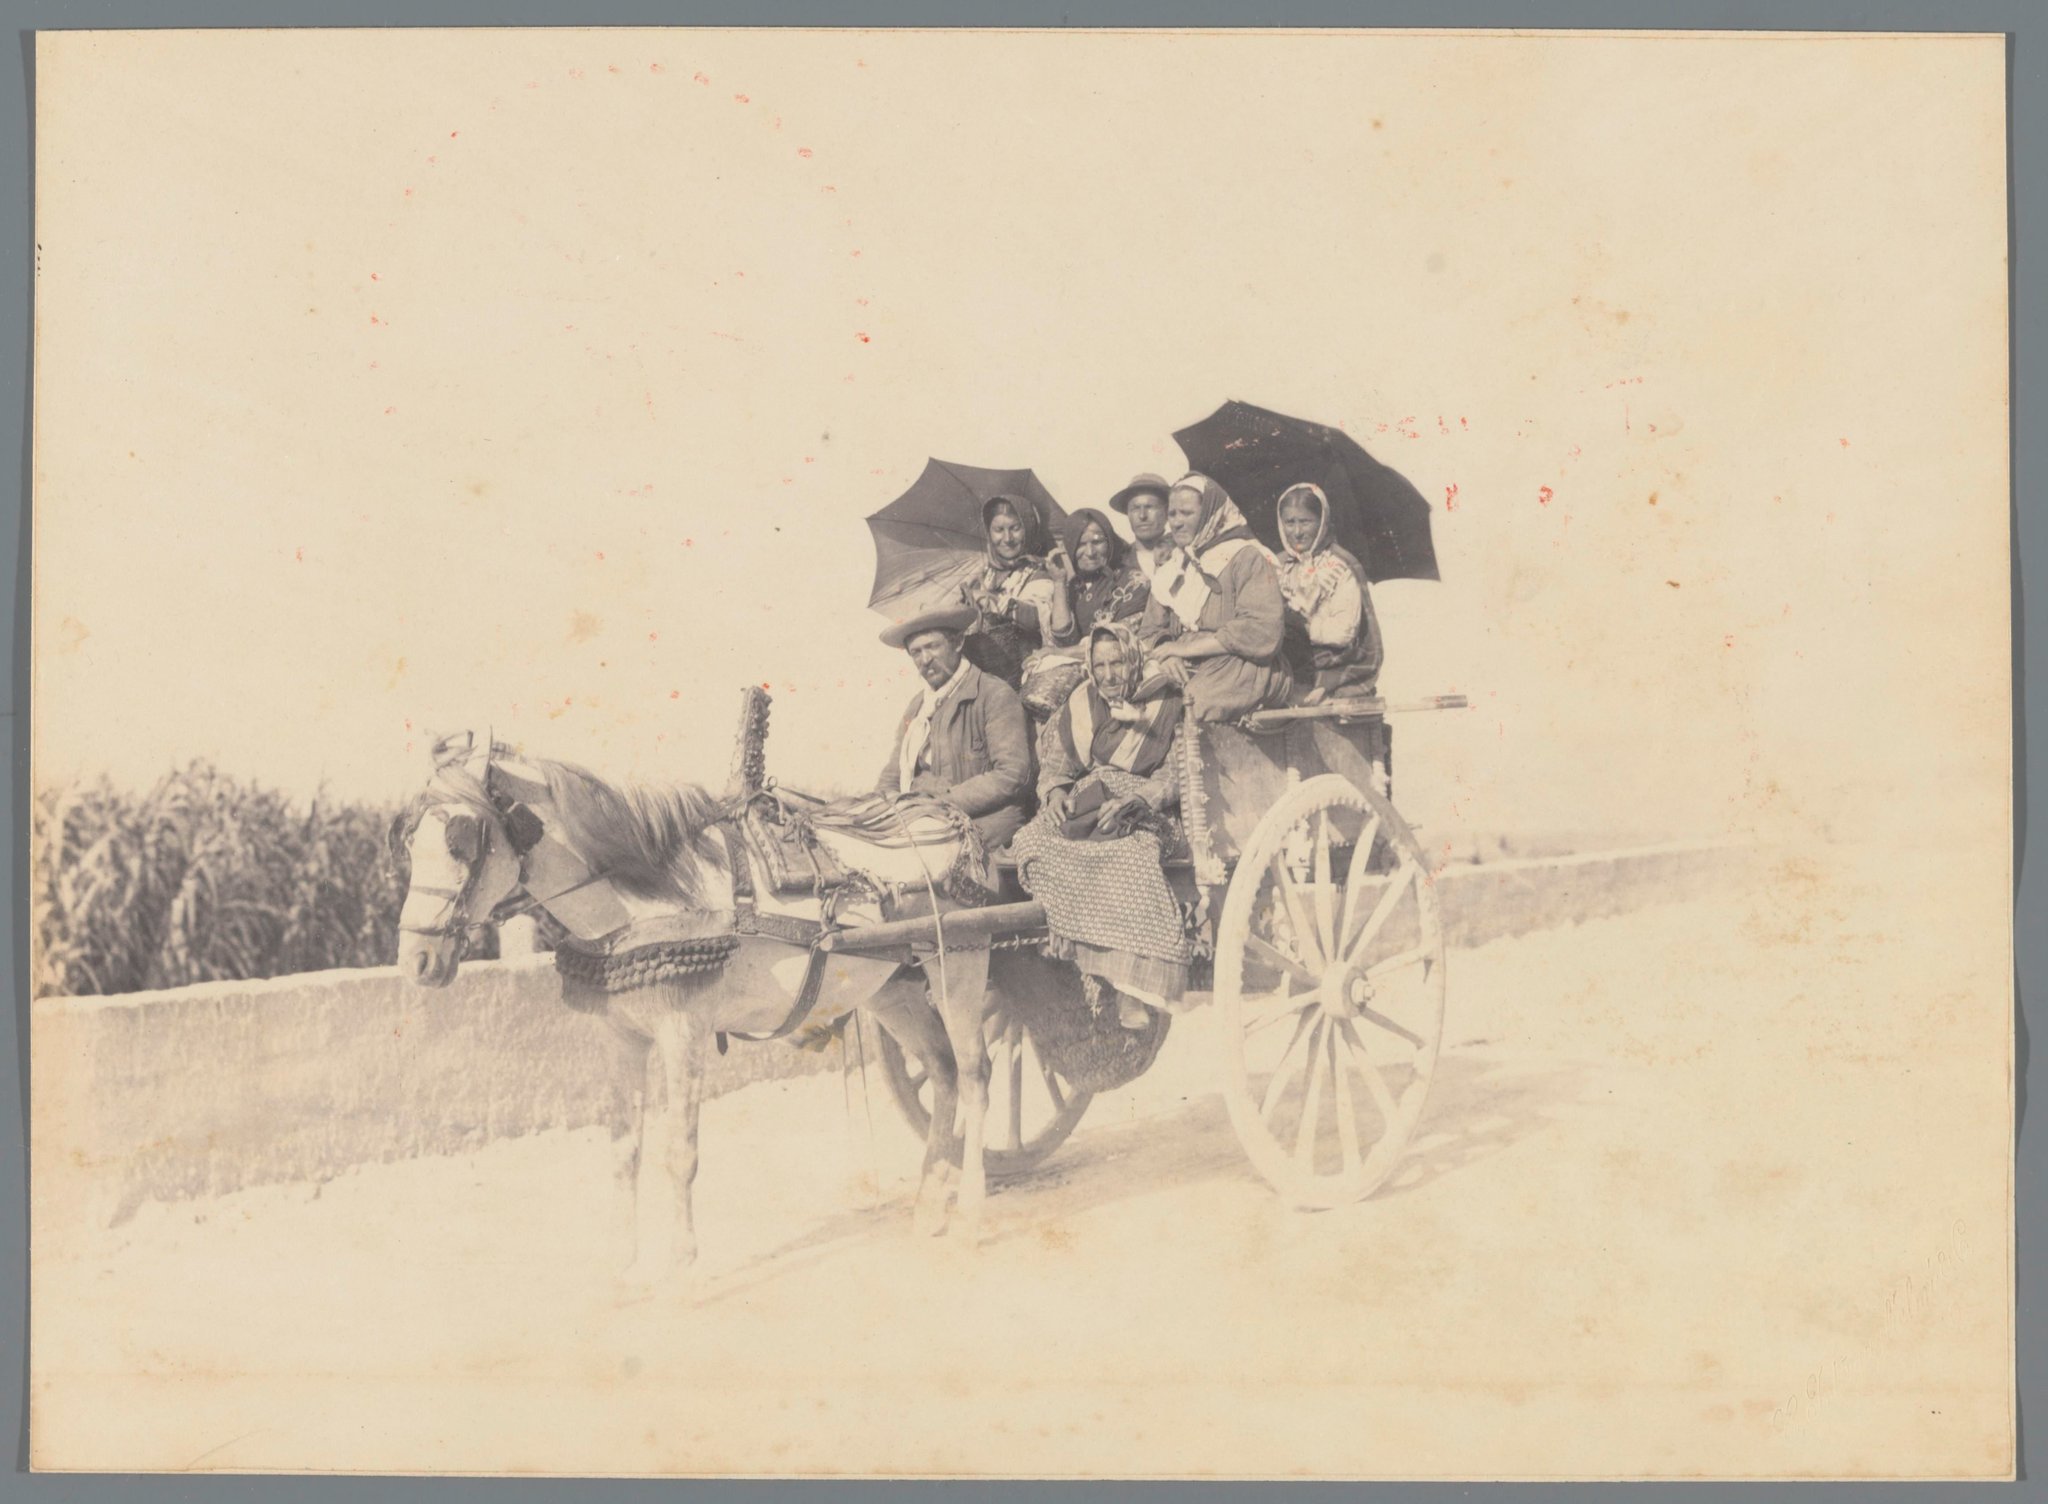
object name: photograph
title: Gezelschap op een Siciliaanse kar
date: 1880-1890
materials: cardboard, paper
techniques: albumen print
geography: palermo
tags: two-wheeled vehicle drawn by one animal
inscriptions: inscription: ‘Sicilië’